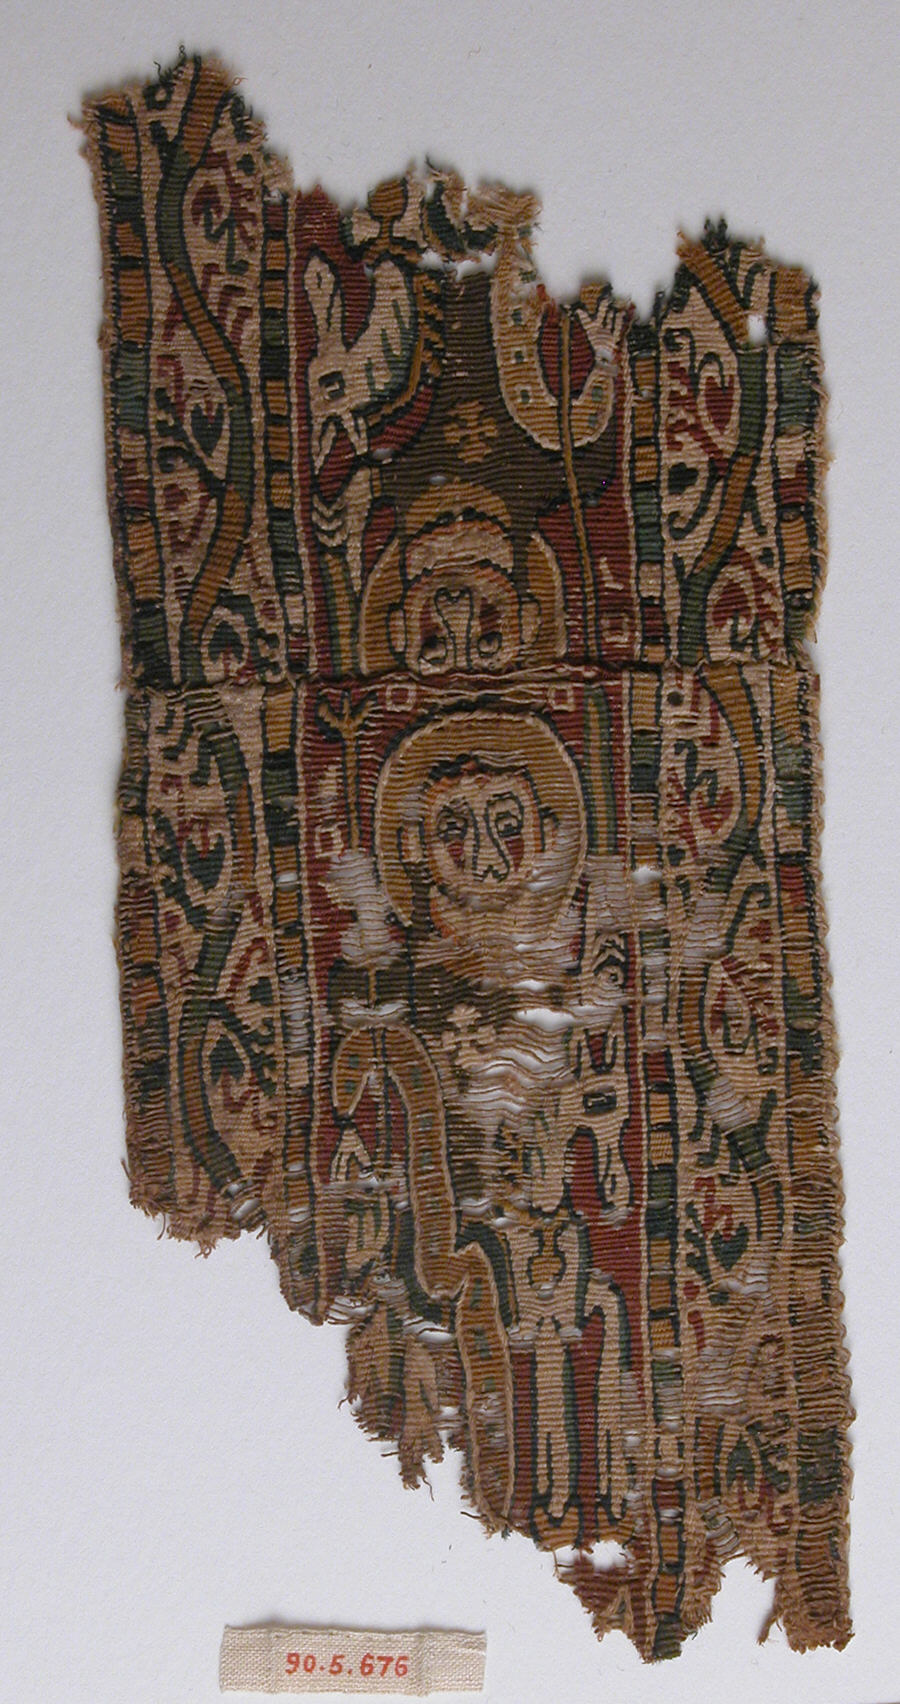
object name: textile fragment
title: Fragment of Shoulder Band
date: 501-700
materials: linen, wool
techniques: weave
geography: egypt